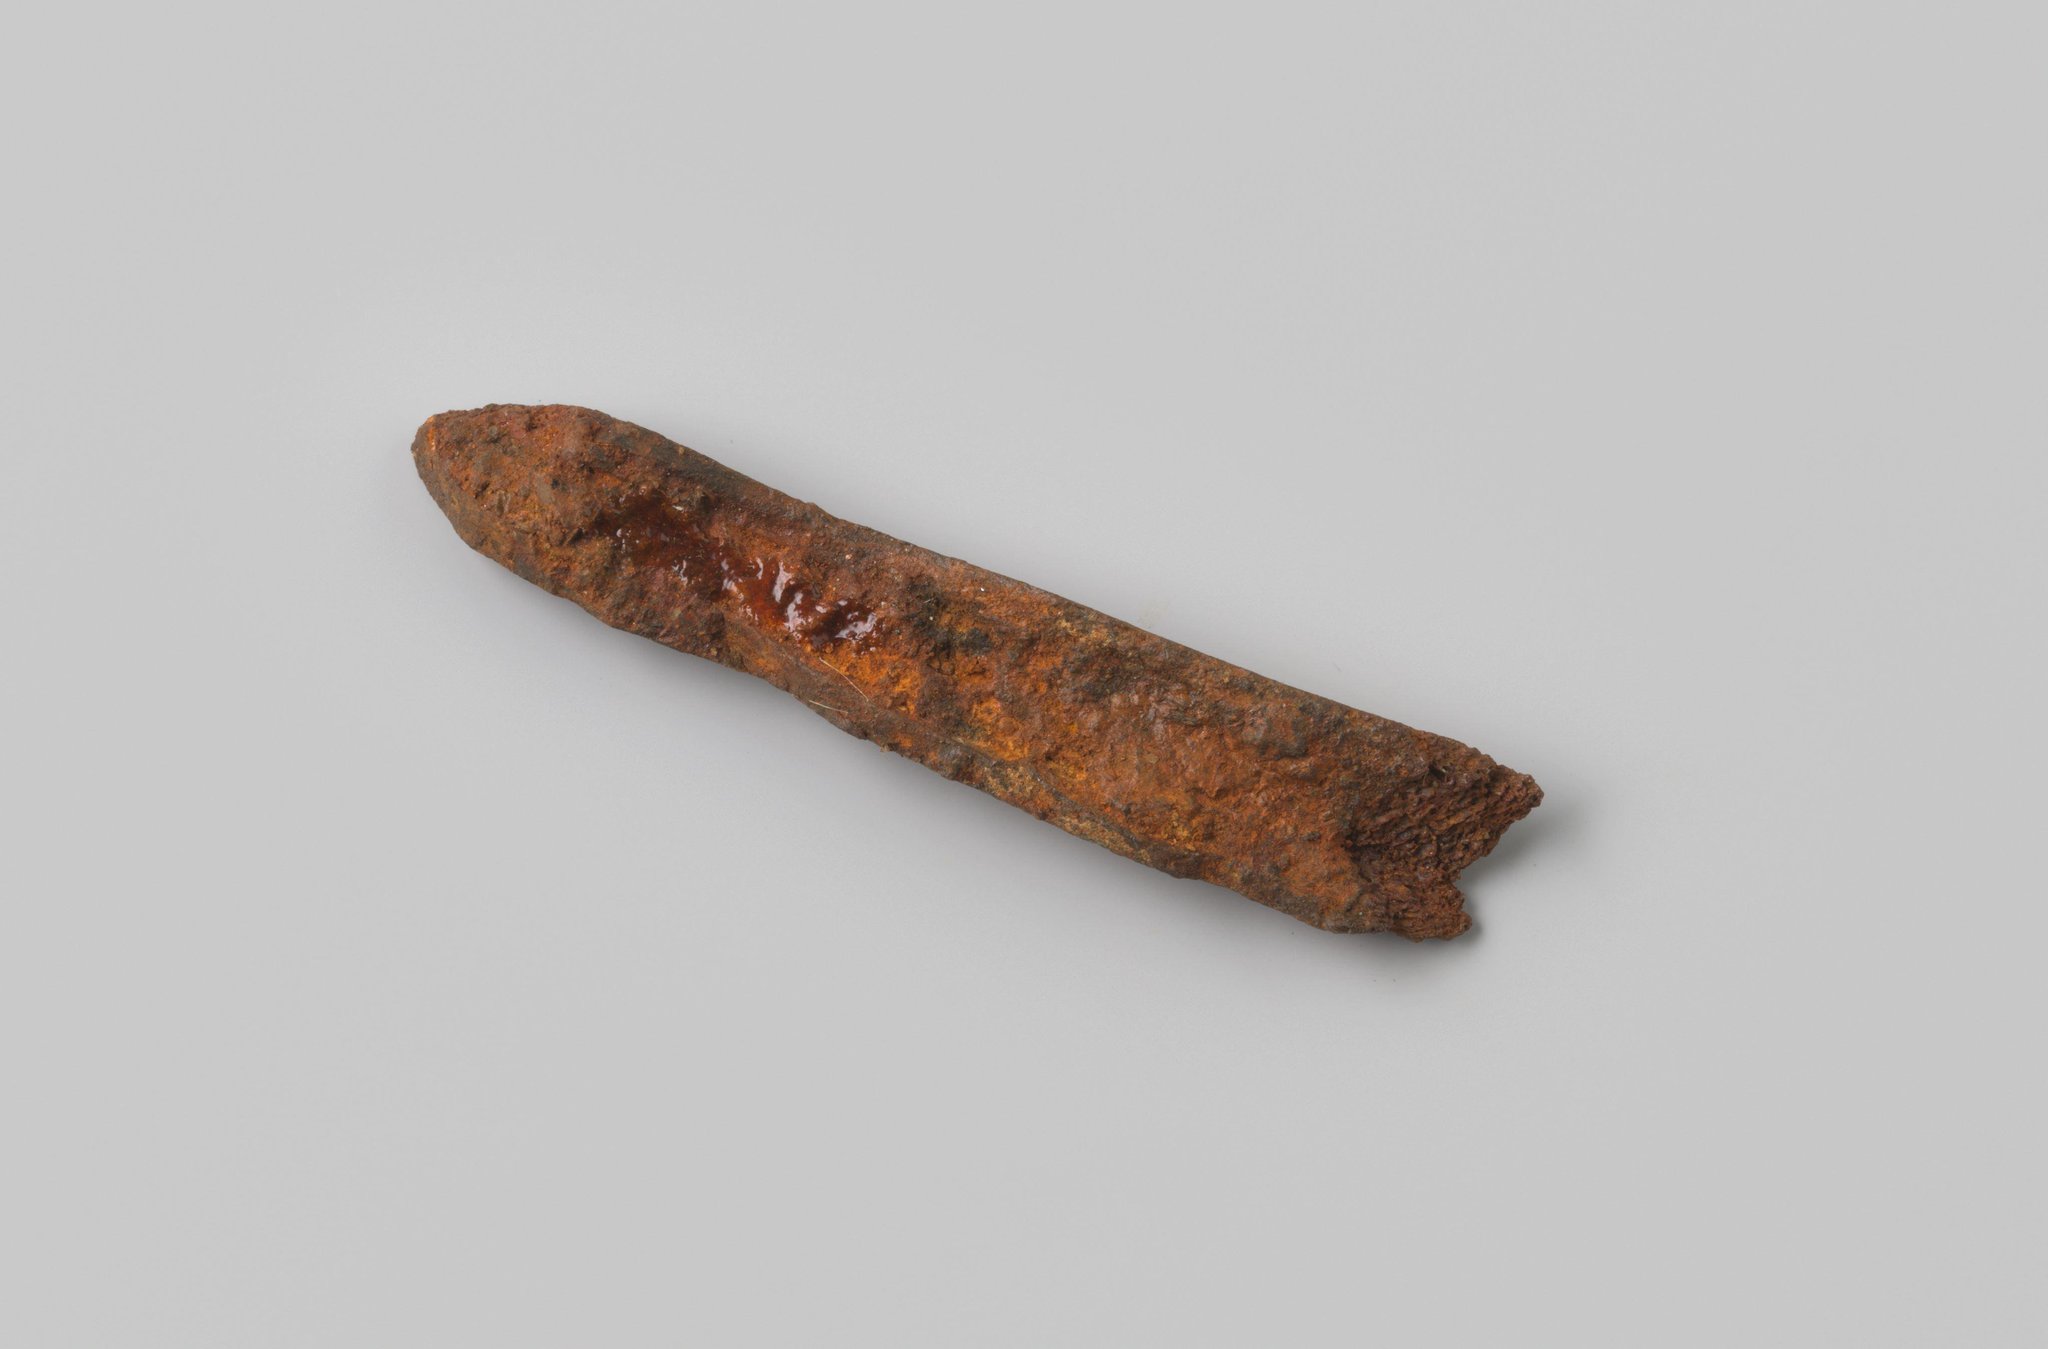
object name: bone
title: Fragment dierlijk rib uit het wrak van de Oost-Indiëvaarder Hollandia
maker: niet van toepassing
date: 1700-1743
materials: bone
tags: verenigde oostindische compagnie, hollandia (schip), annet